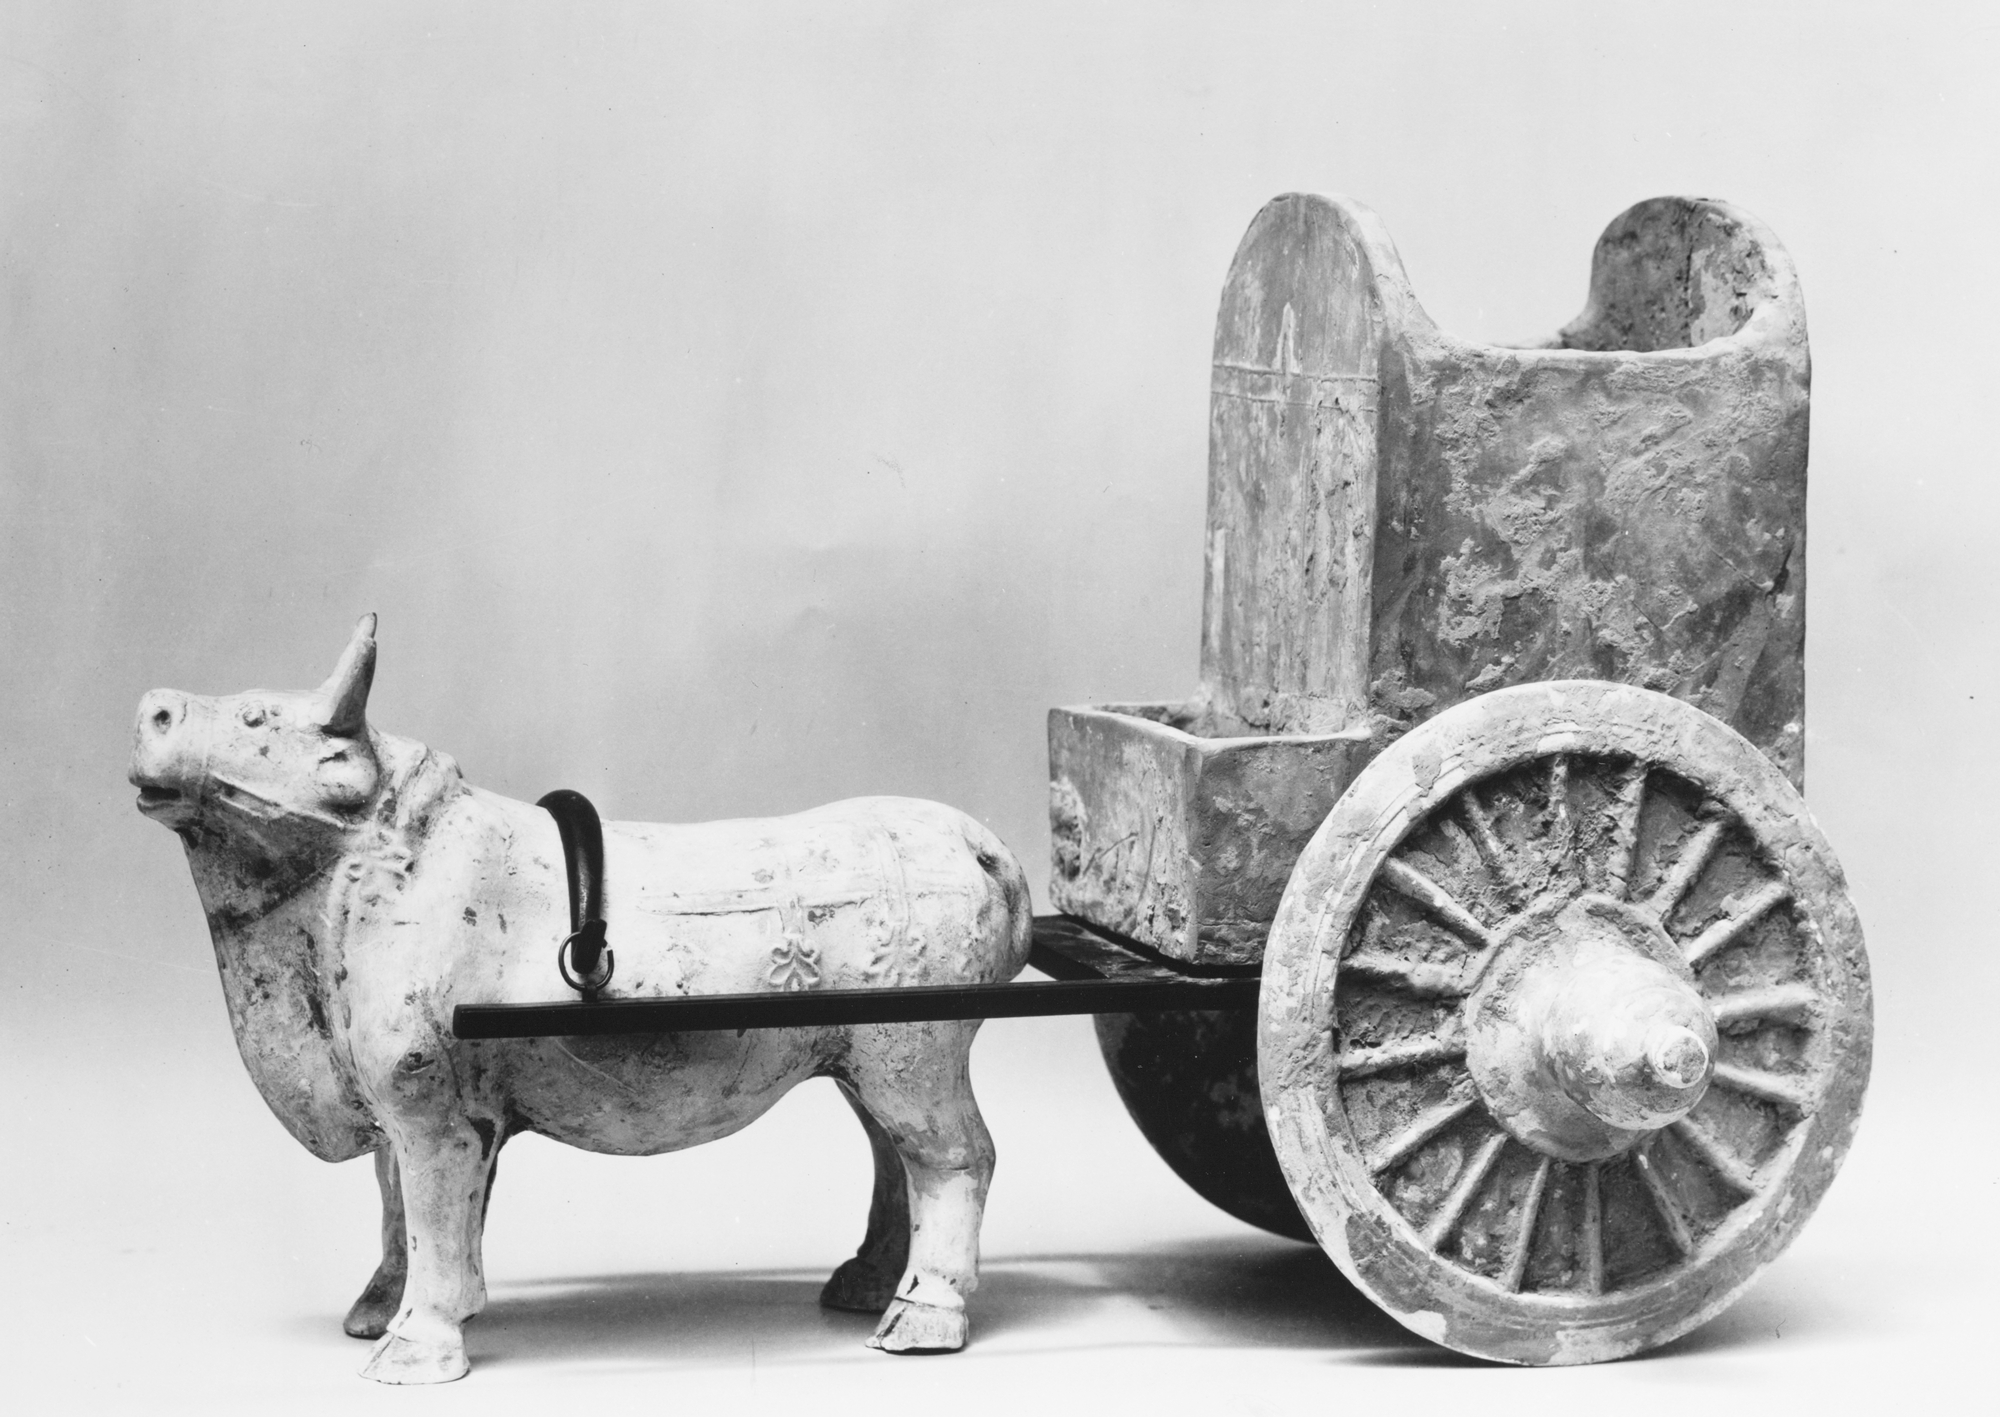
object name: figure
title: Ox cart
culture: chinese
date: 601-800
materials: earthenware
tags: carts,ox